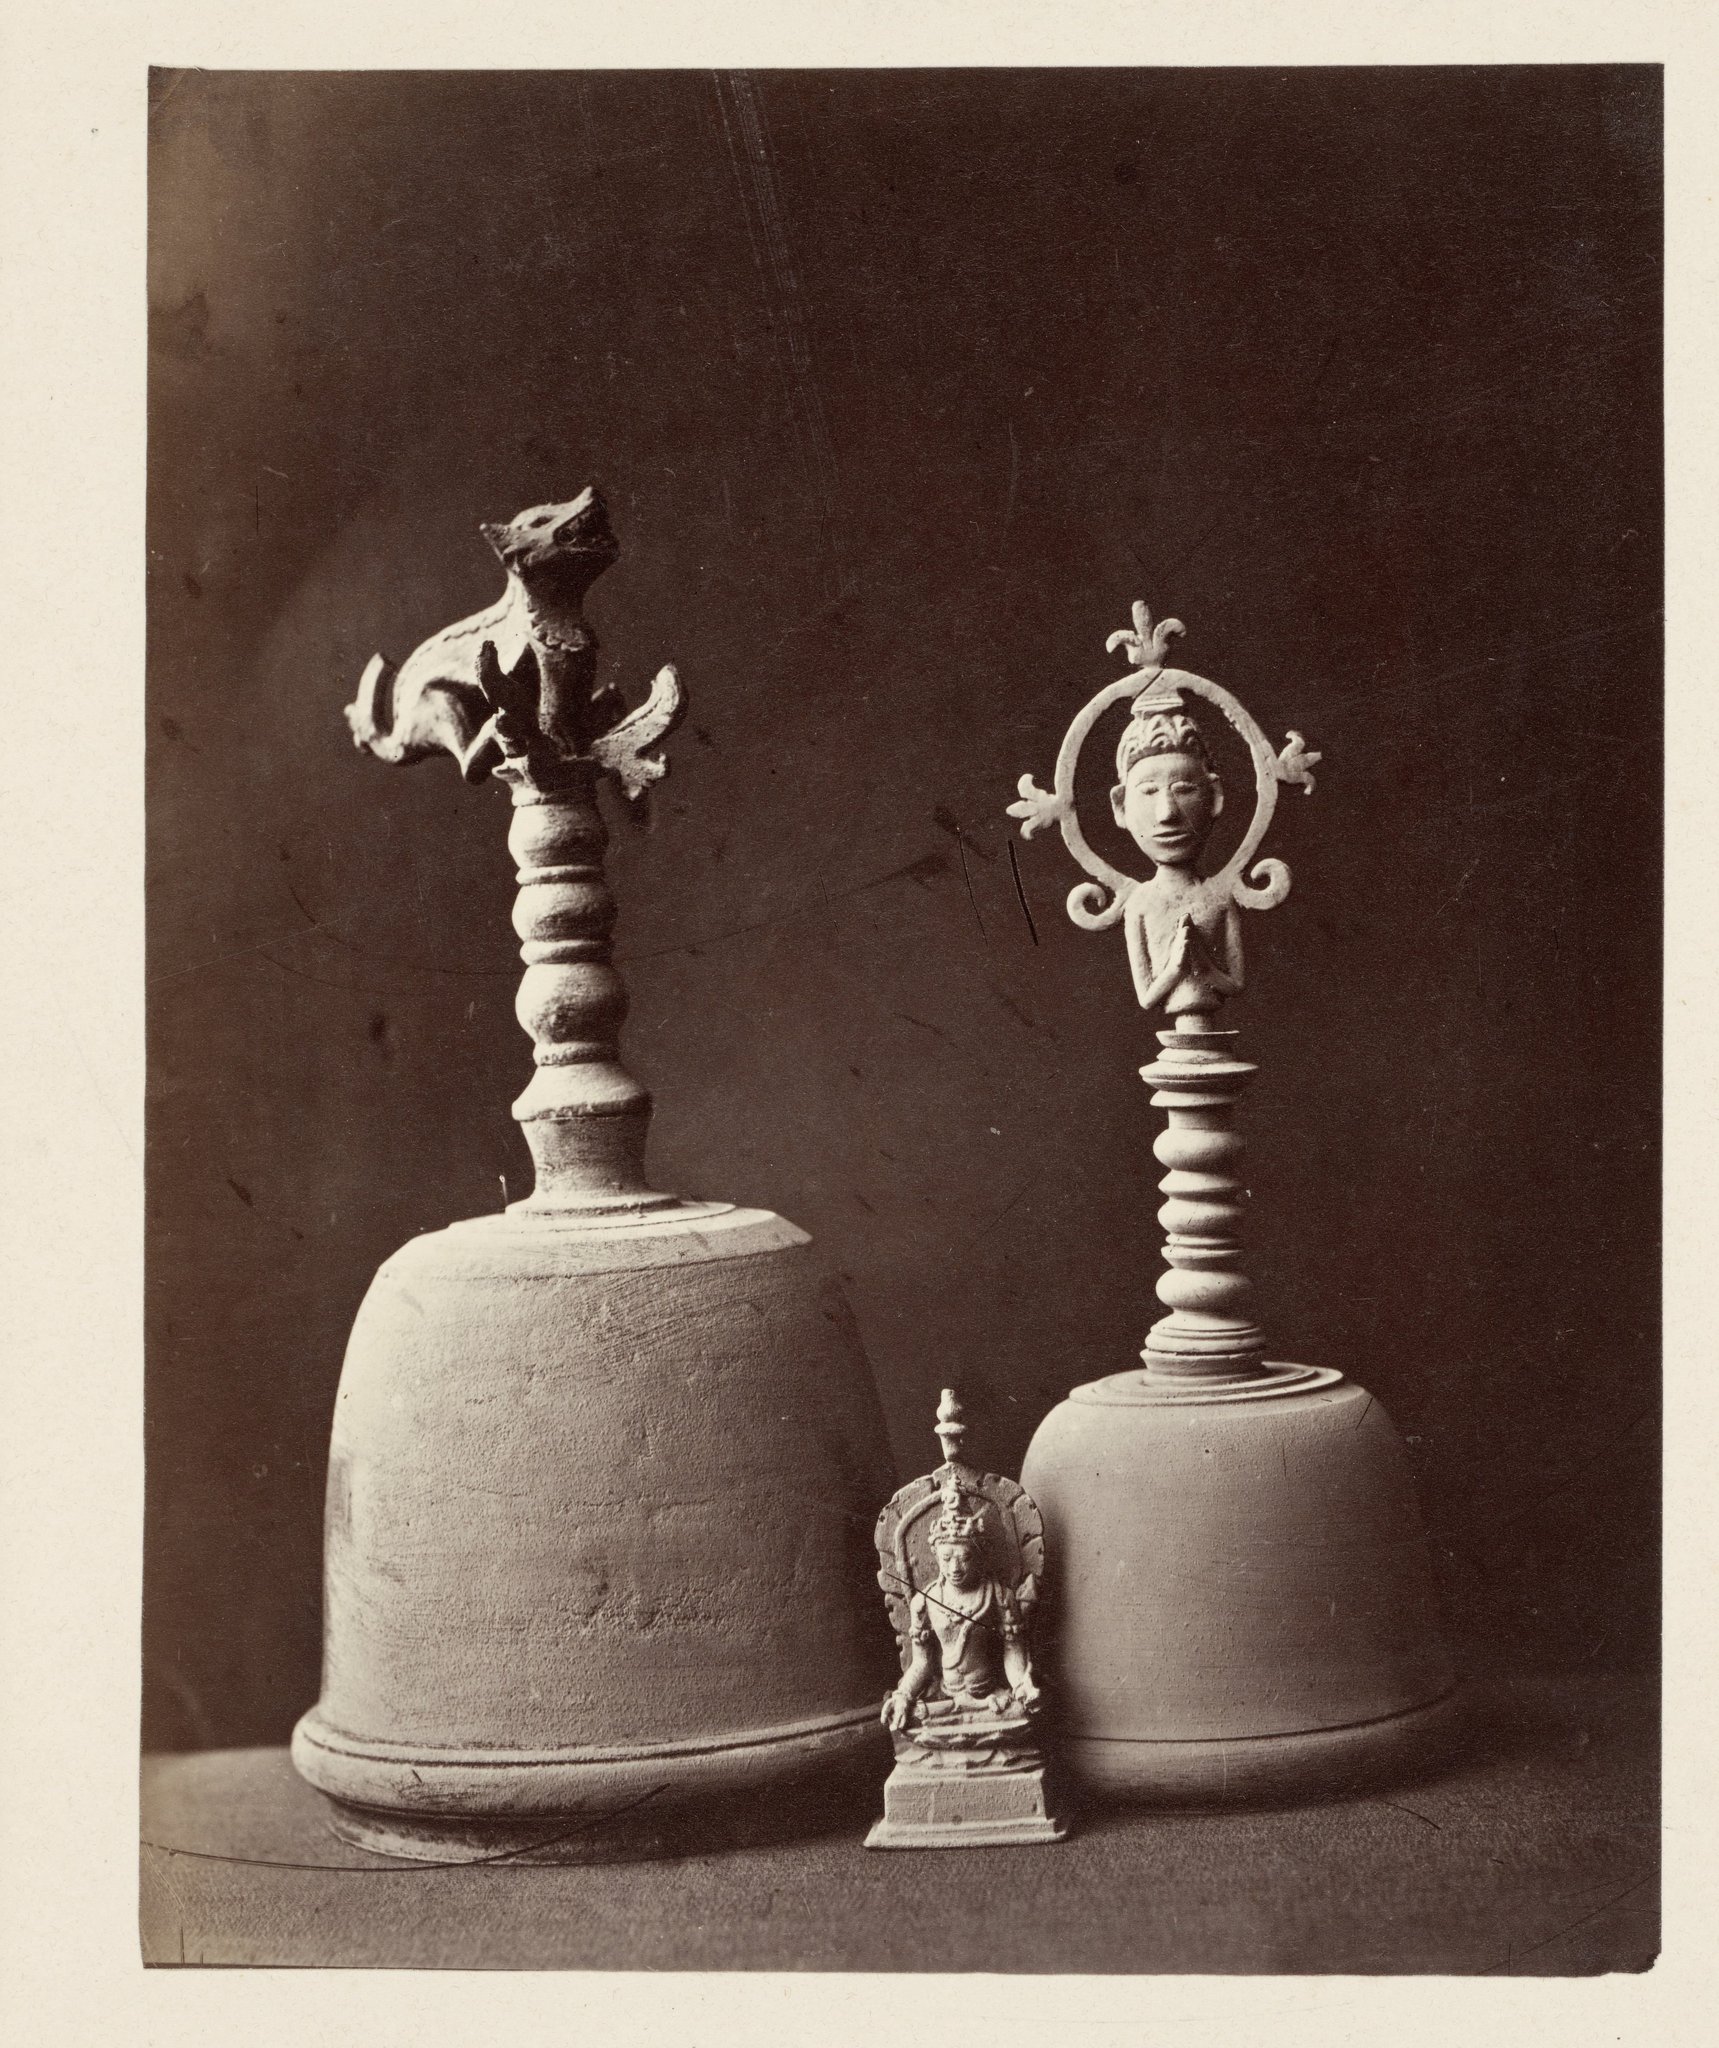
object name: photograph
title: Two bronze handbells and a statuette of bodhisattva Padmapani. Talaga, Cirebon district, West Java province, 9th and 16th century, Indonesia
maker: isidore kinsbergen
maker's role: fotograaf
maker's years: 1821-1905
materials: cardboard, paper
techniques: albumen print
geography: java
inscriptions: title: ‘Twee bellen (een genaamd Santri manik) en zittend beeldje, naam onbekend Cat. no. 69 te Telaga (Residentie cheribon)’, number: ‘68’